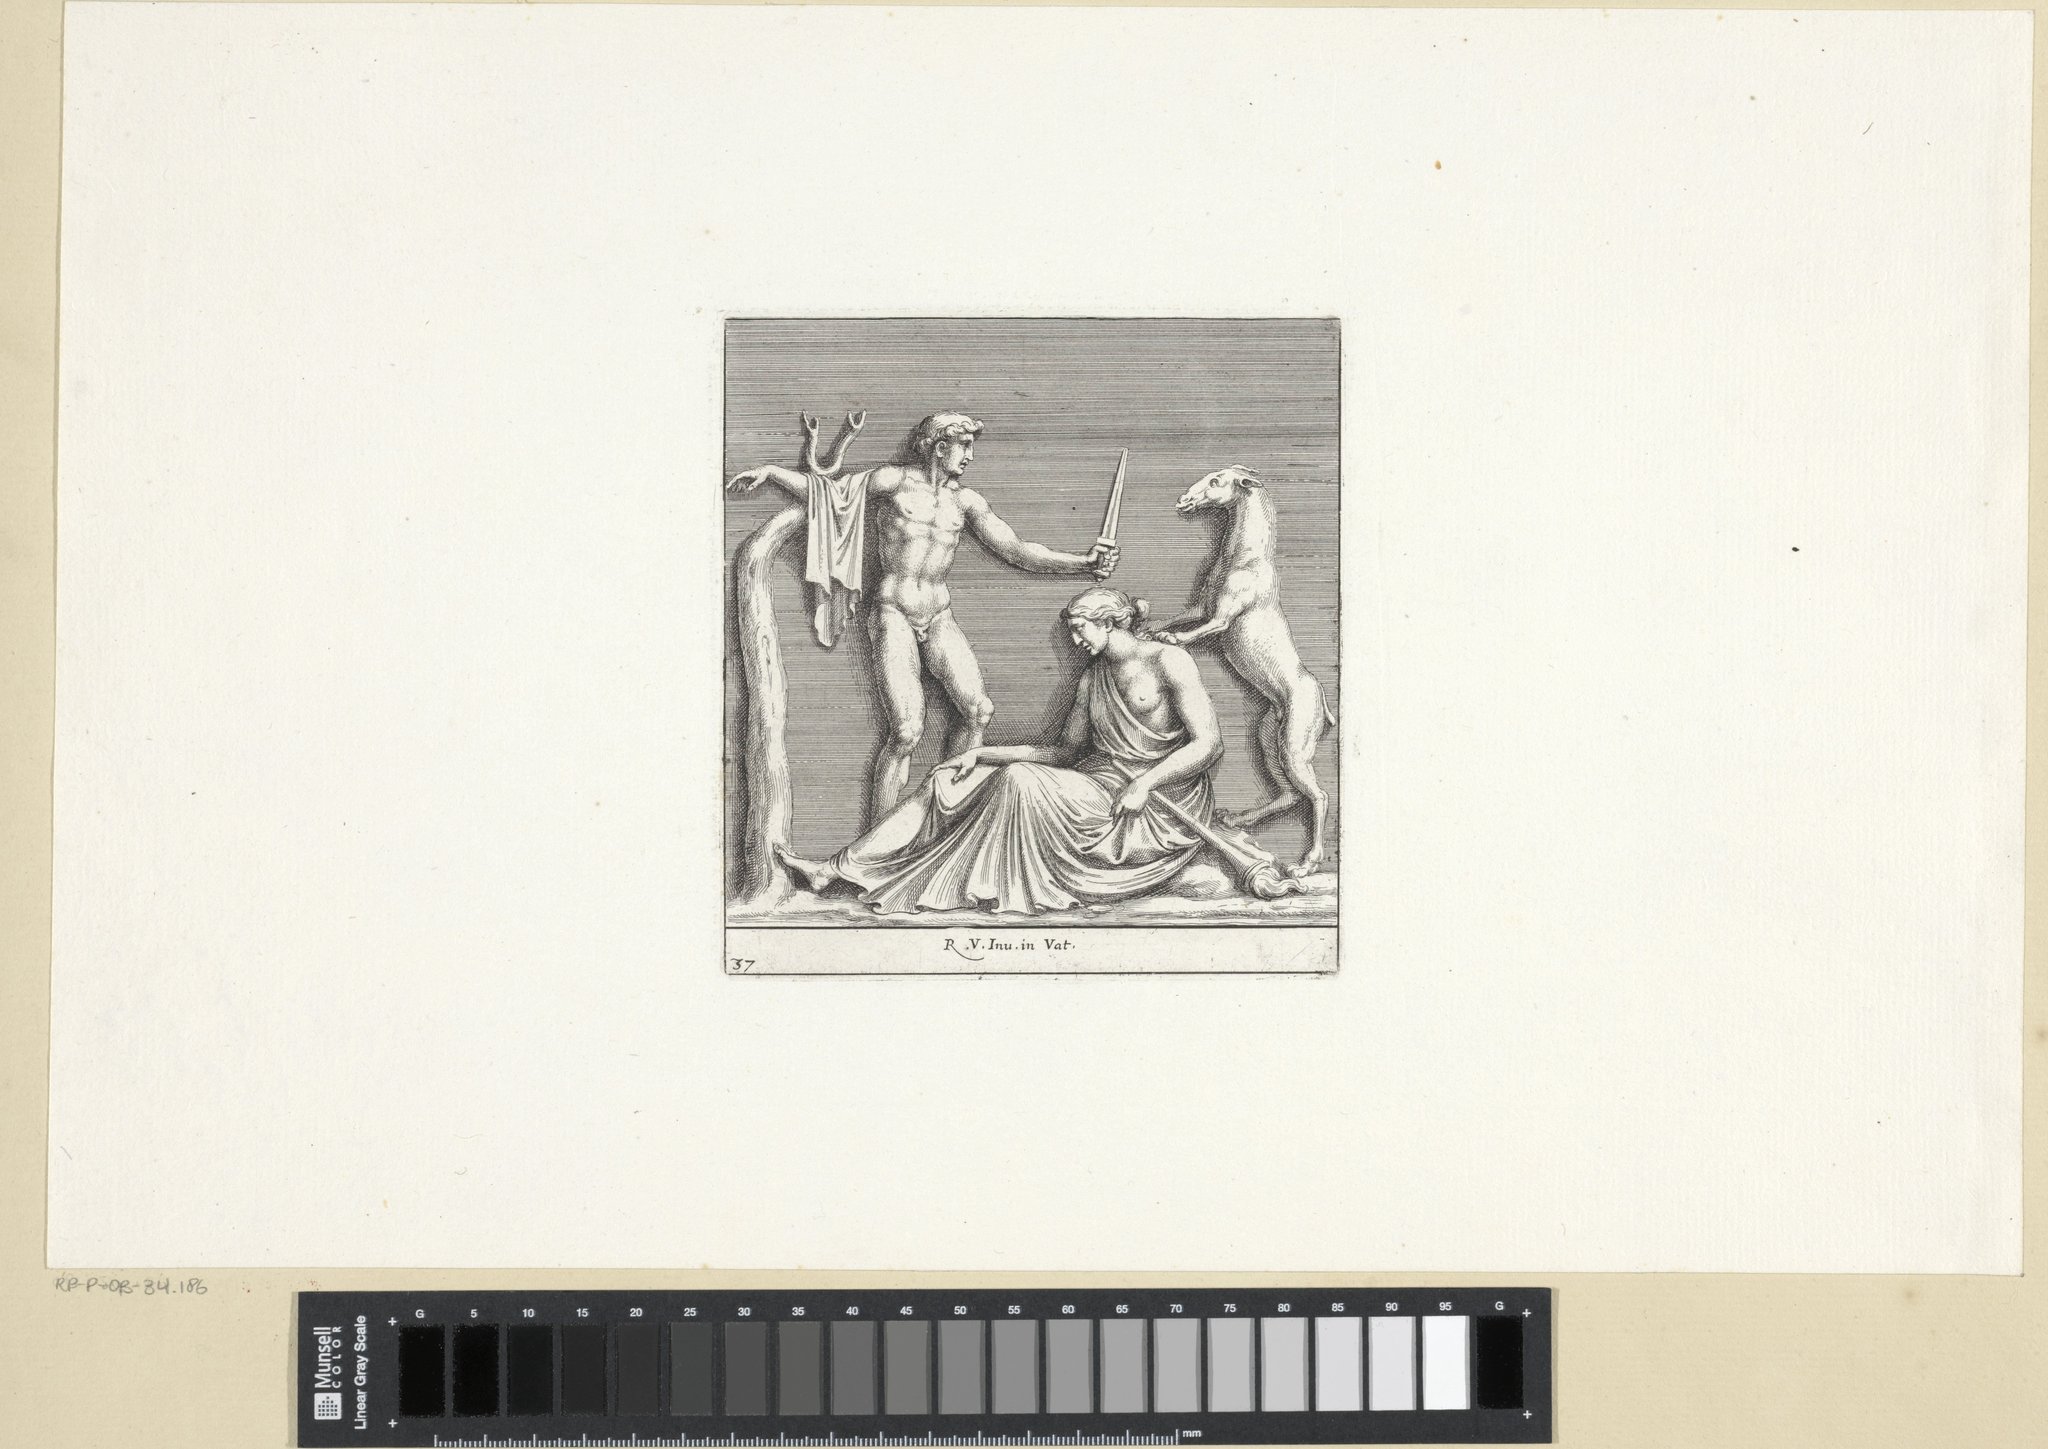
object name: print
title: Reliëfs in de Loggia van Rafaël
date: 1645-1700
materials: paper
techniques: engraving, etching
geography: vatican city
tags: hacking and thrusting weapons: dagger, mis-shapen animals; monsters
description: Een man met een dolk (Orestes?) staat naast een zittende vrouw (een Erinyen?). Achter de vrouw staat een fantasiewezen.